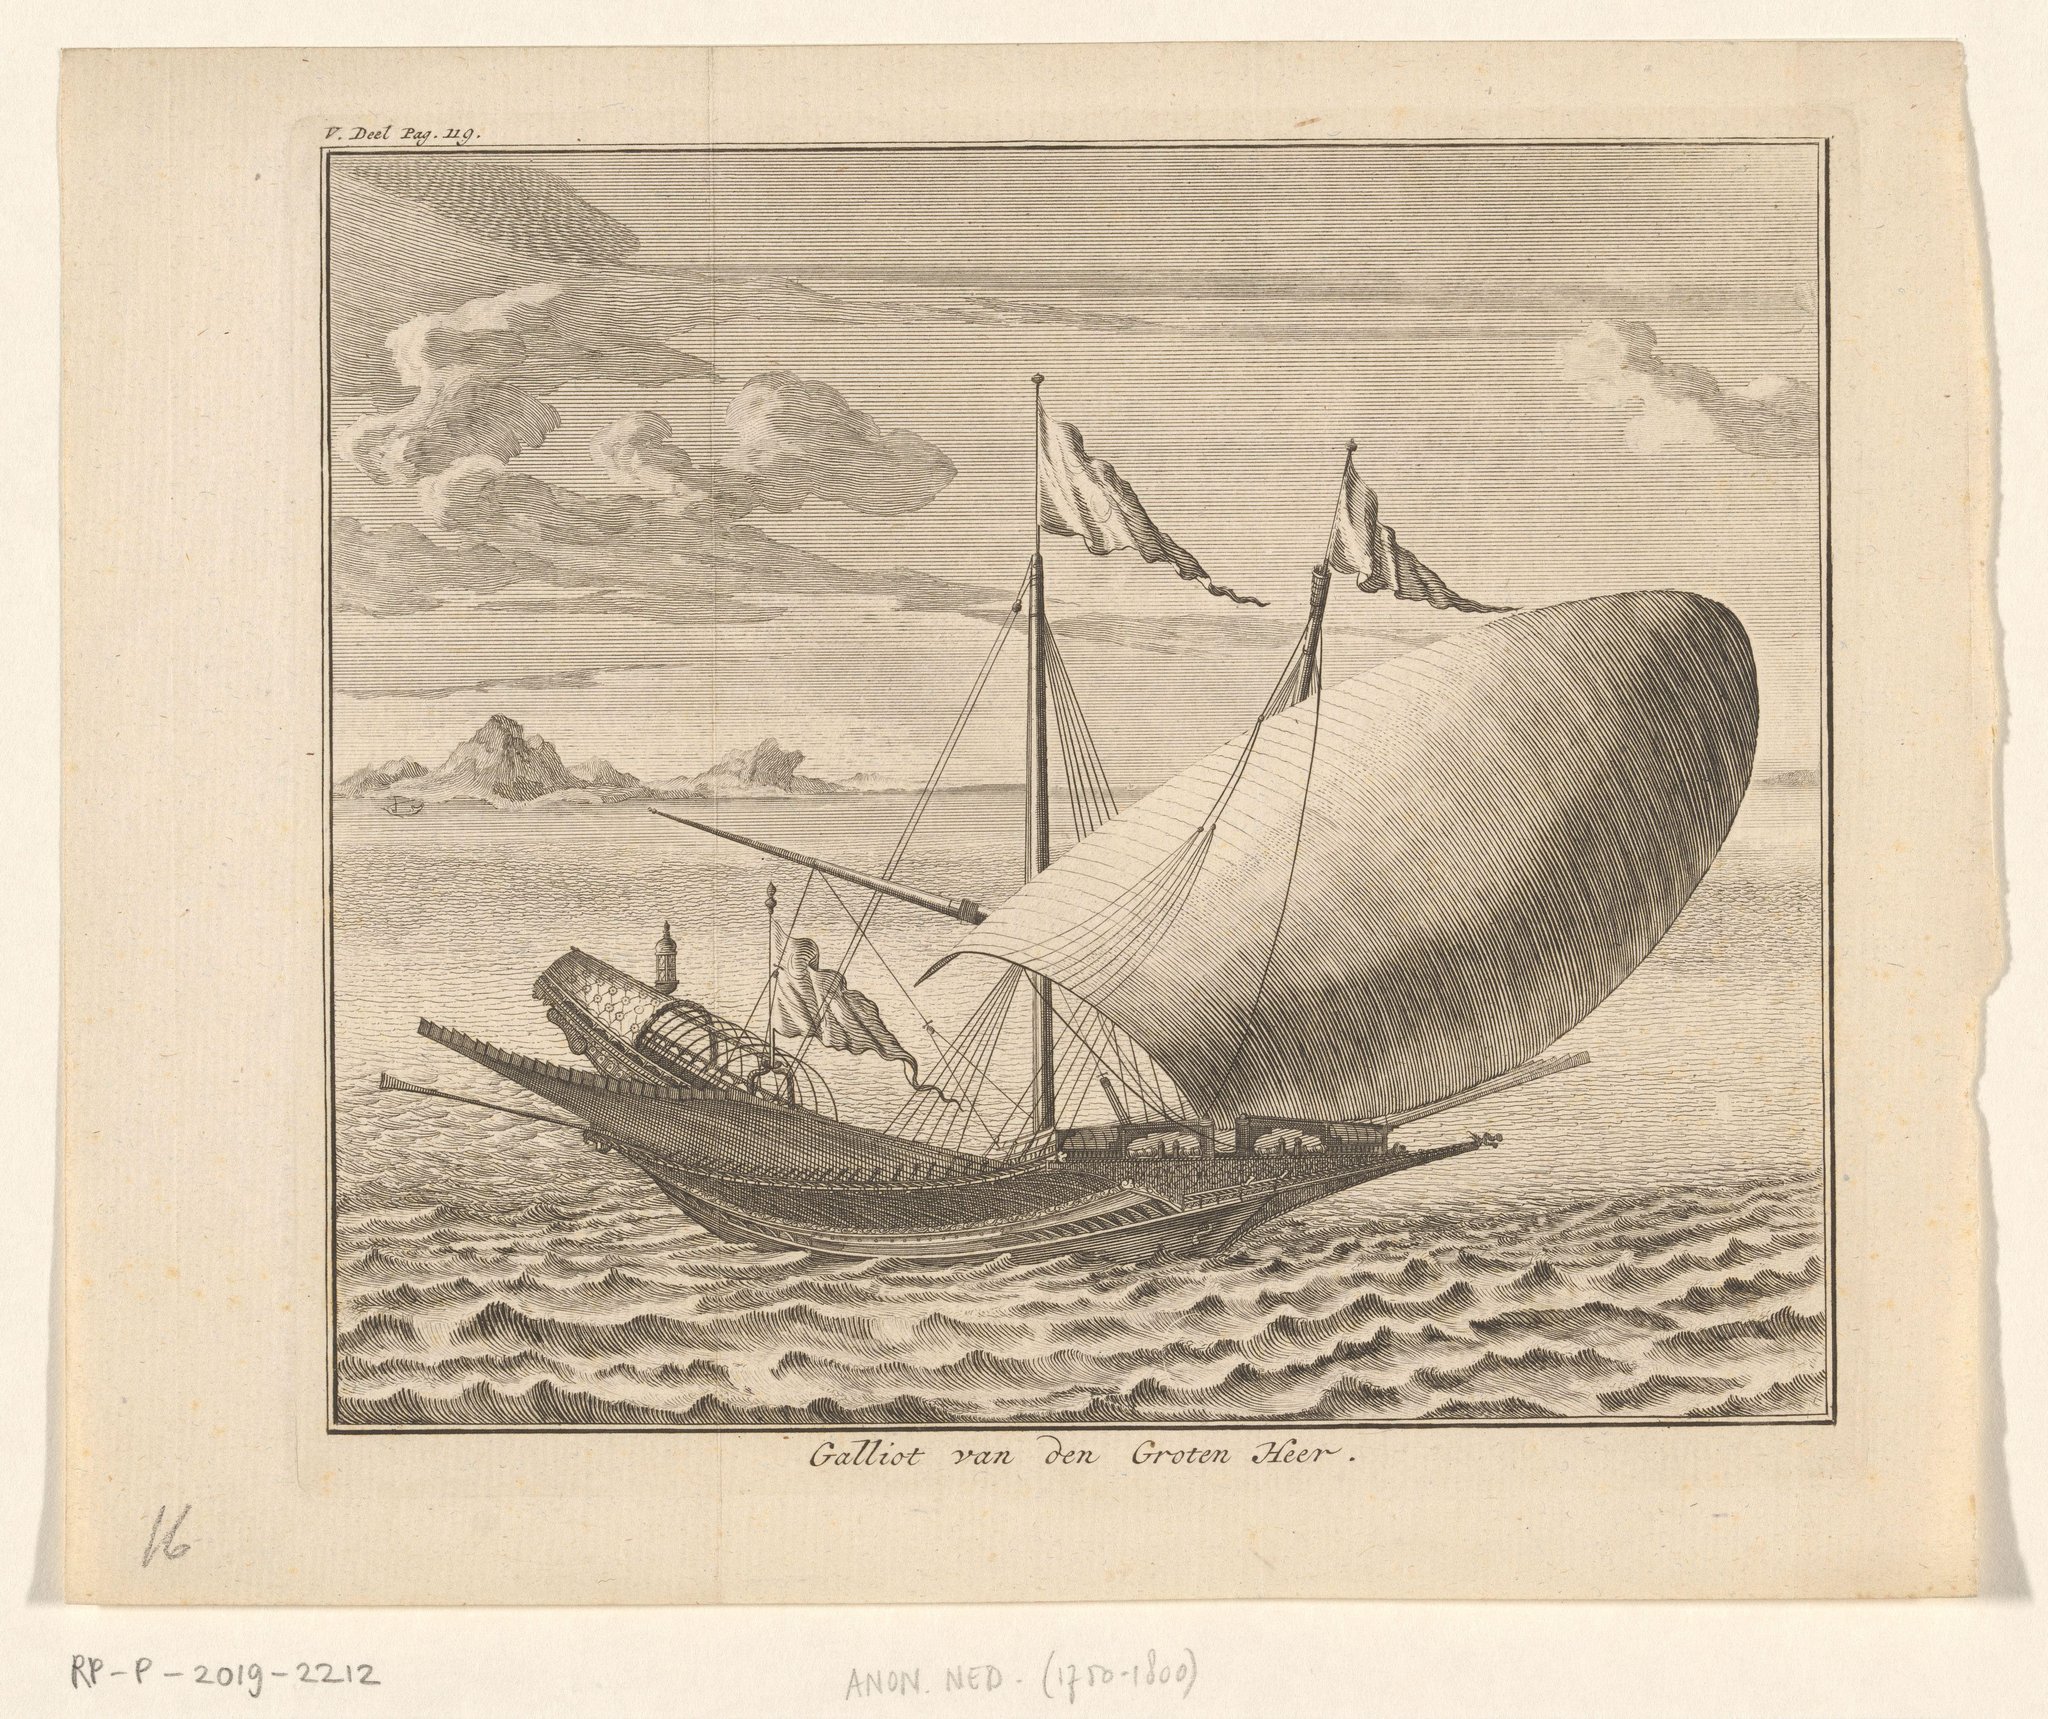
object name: book illustration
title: Galliot van den Groten Heer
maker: Anonymous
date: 1750-1800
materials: paper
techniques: etching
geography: netherlands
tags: sailing-ship, sailing-boat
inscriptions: collector's mark: Lugt 2228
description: Prent uit een onbekend boek. Dit betreft een prent op p. 119 van deel 5.